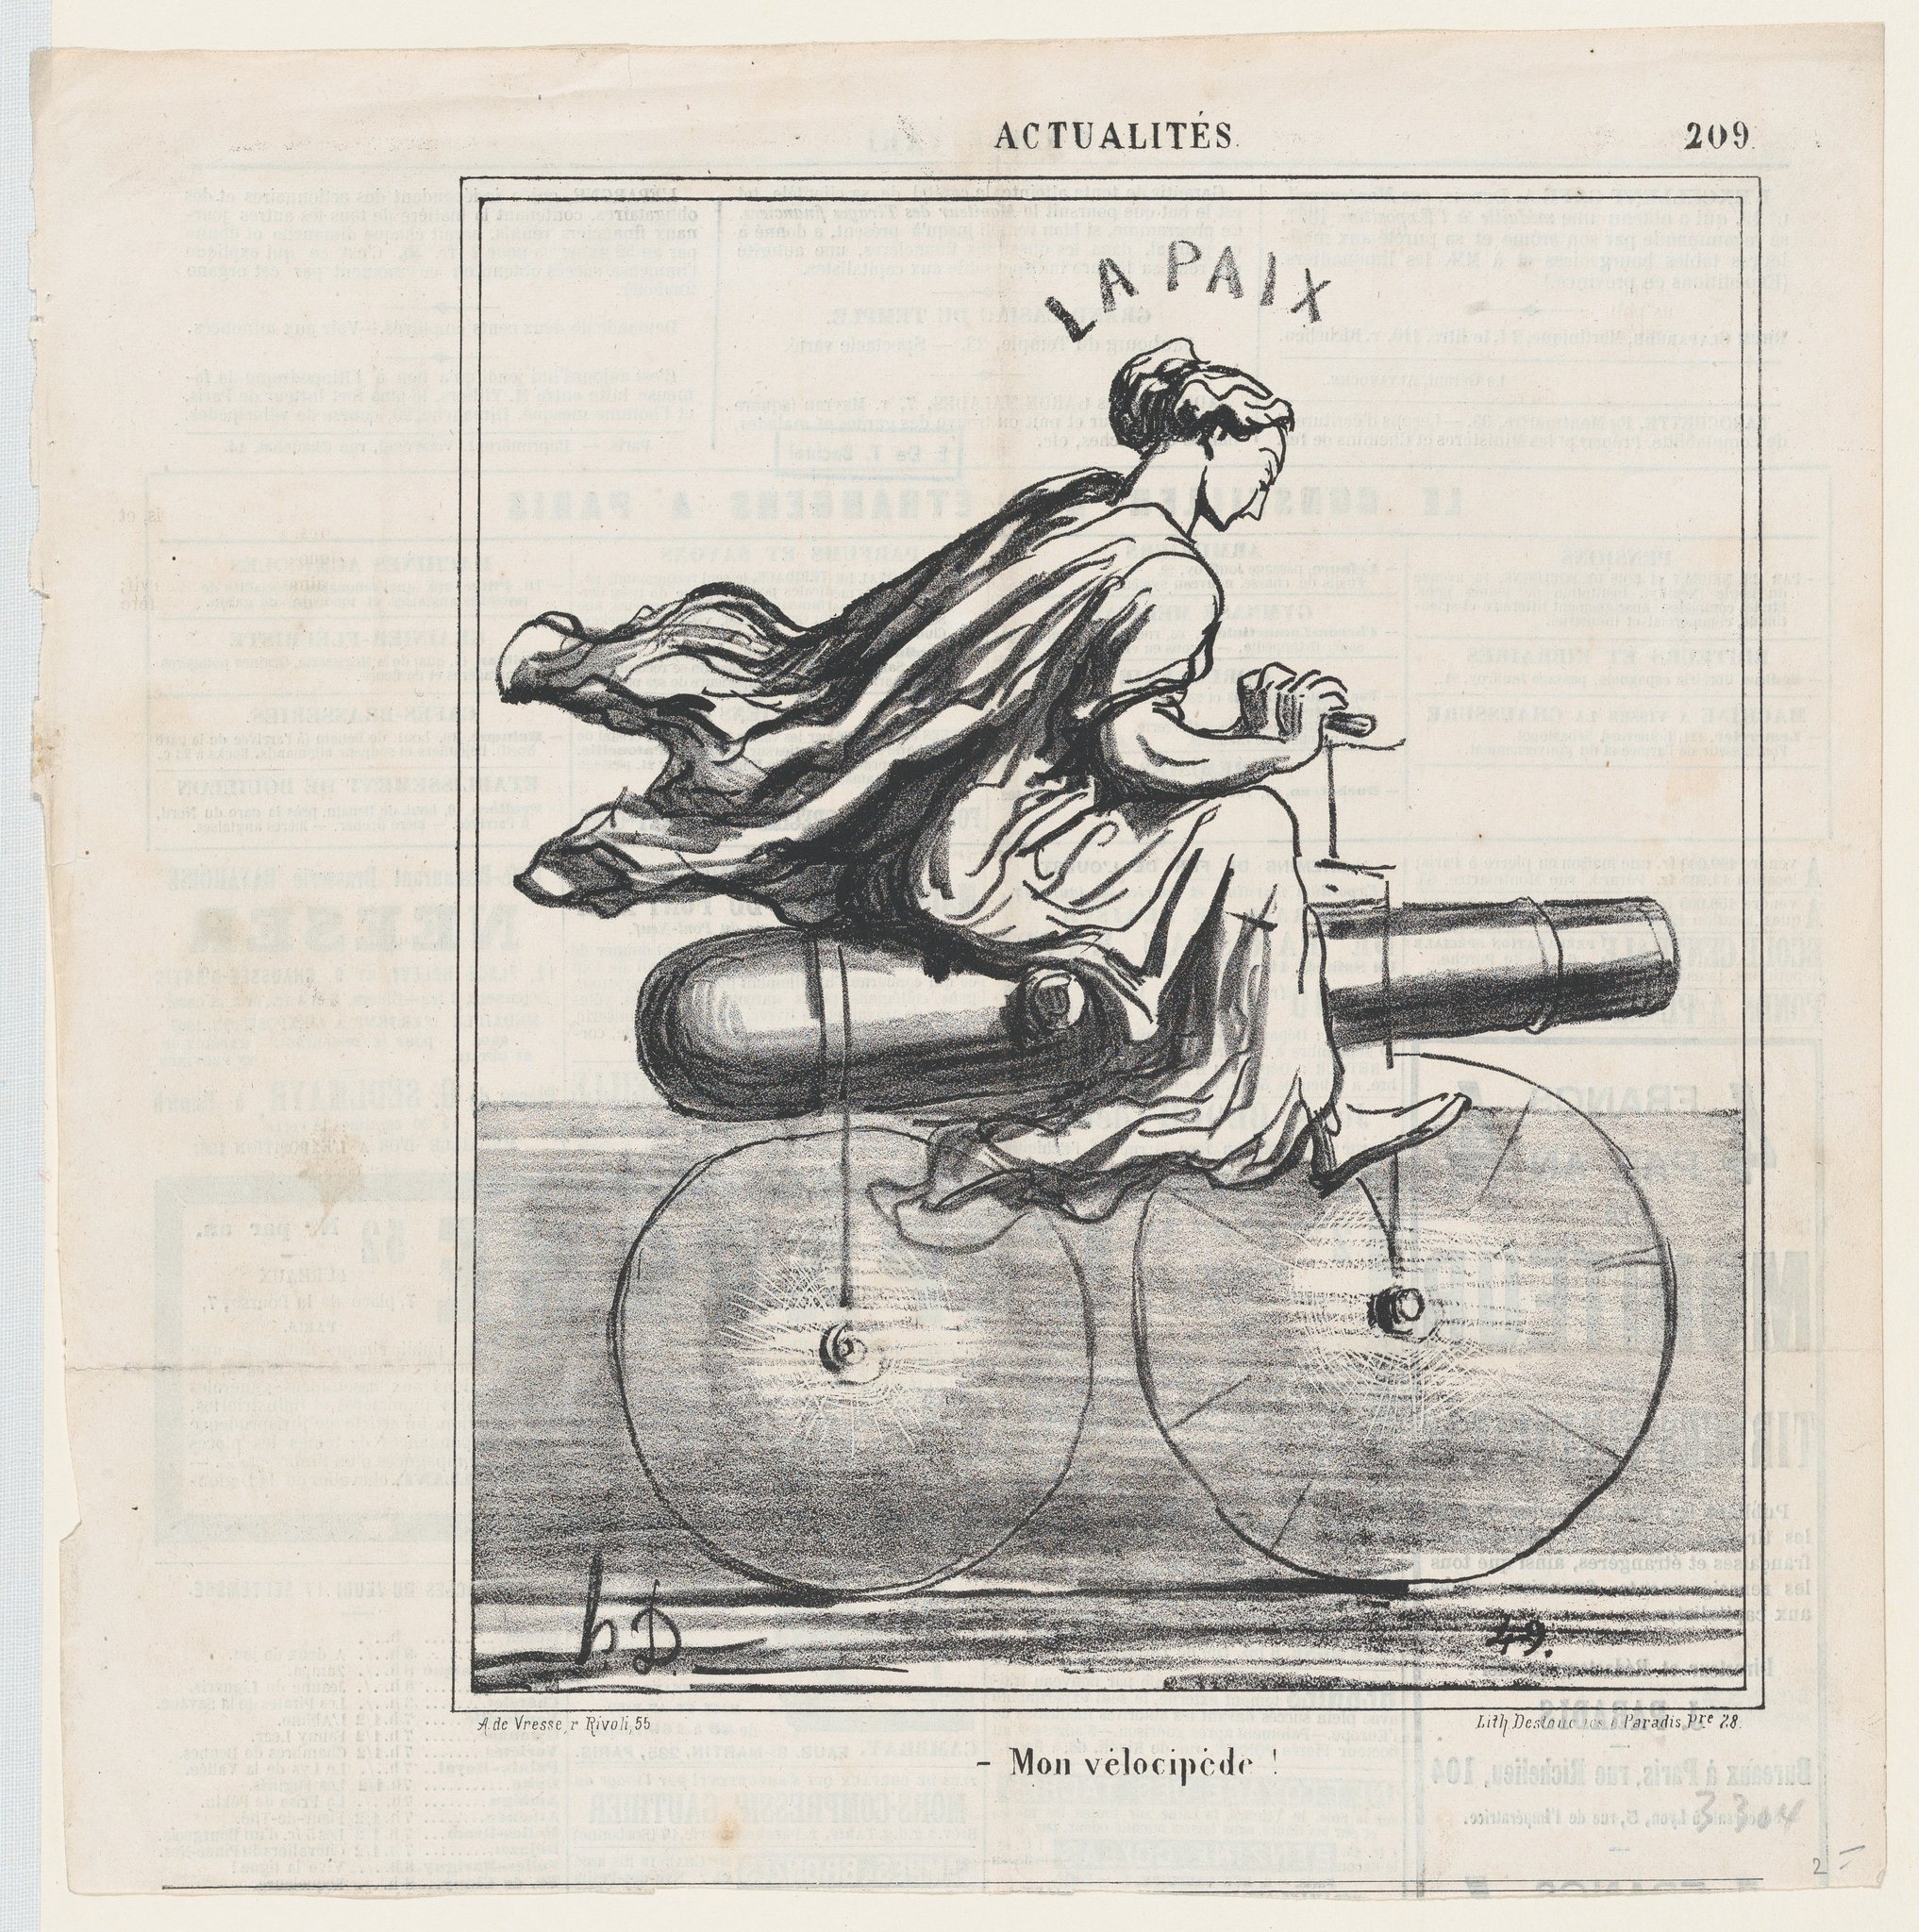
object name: print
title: My bicycle!, from "News of the day"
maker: honoré daumier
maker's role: artist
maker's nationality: french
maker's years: 1808-1879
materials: paper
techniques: lithograph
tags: women,bicycles